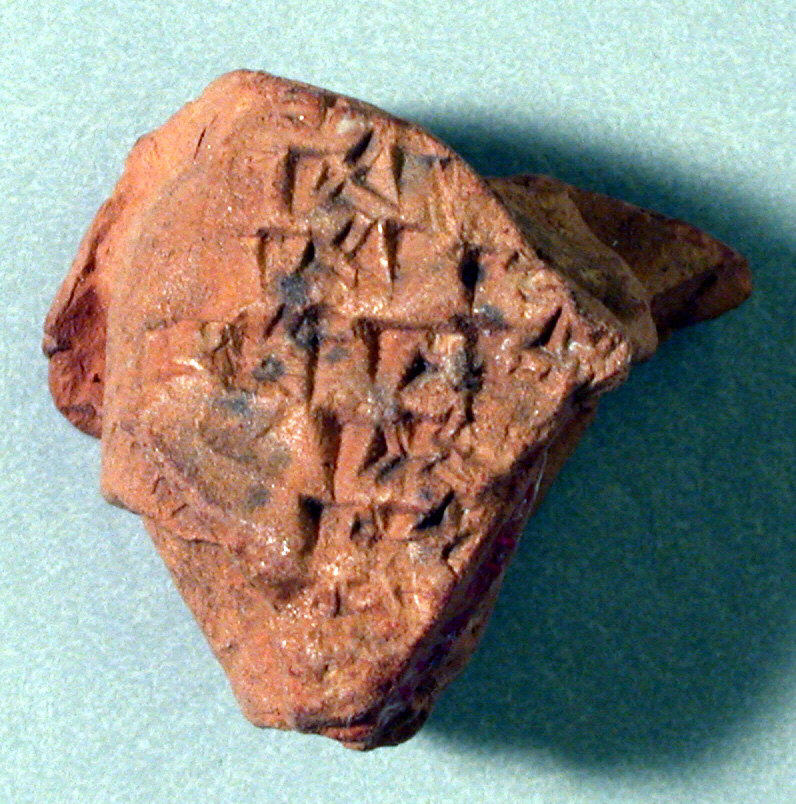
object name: cuneiform tablet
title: Cuneiform tablet: fragment of an exercise tablet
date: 333-1 BCE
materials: clay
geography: mesopotamia